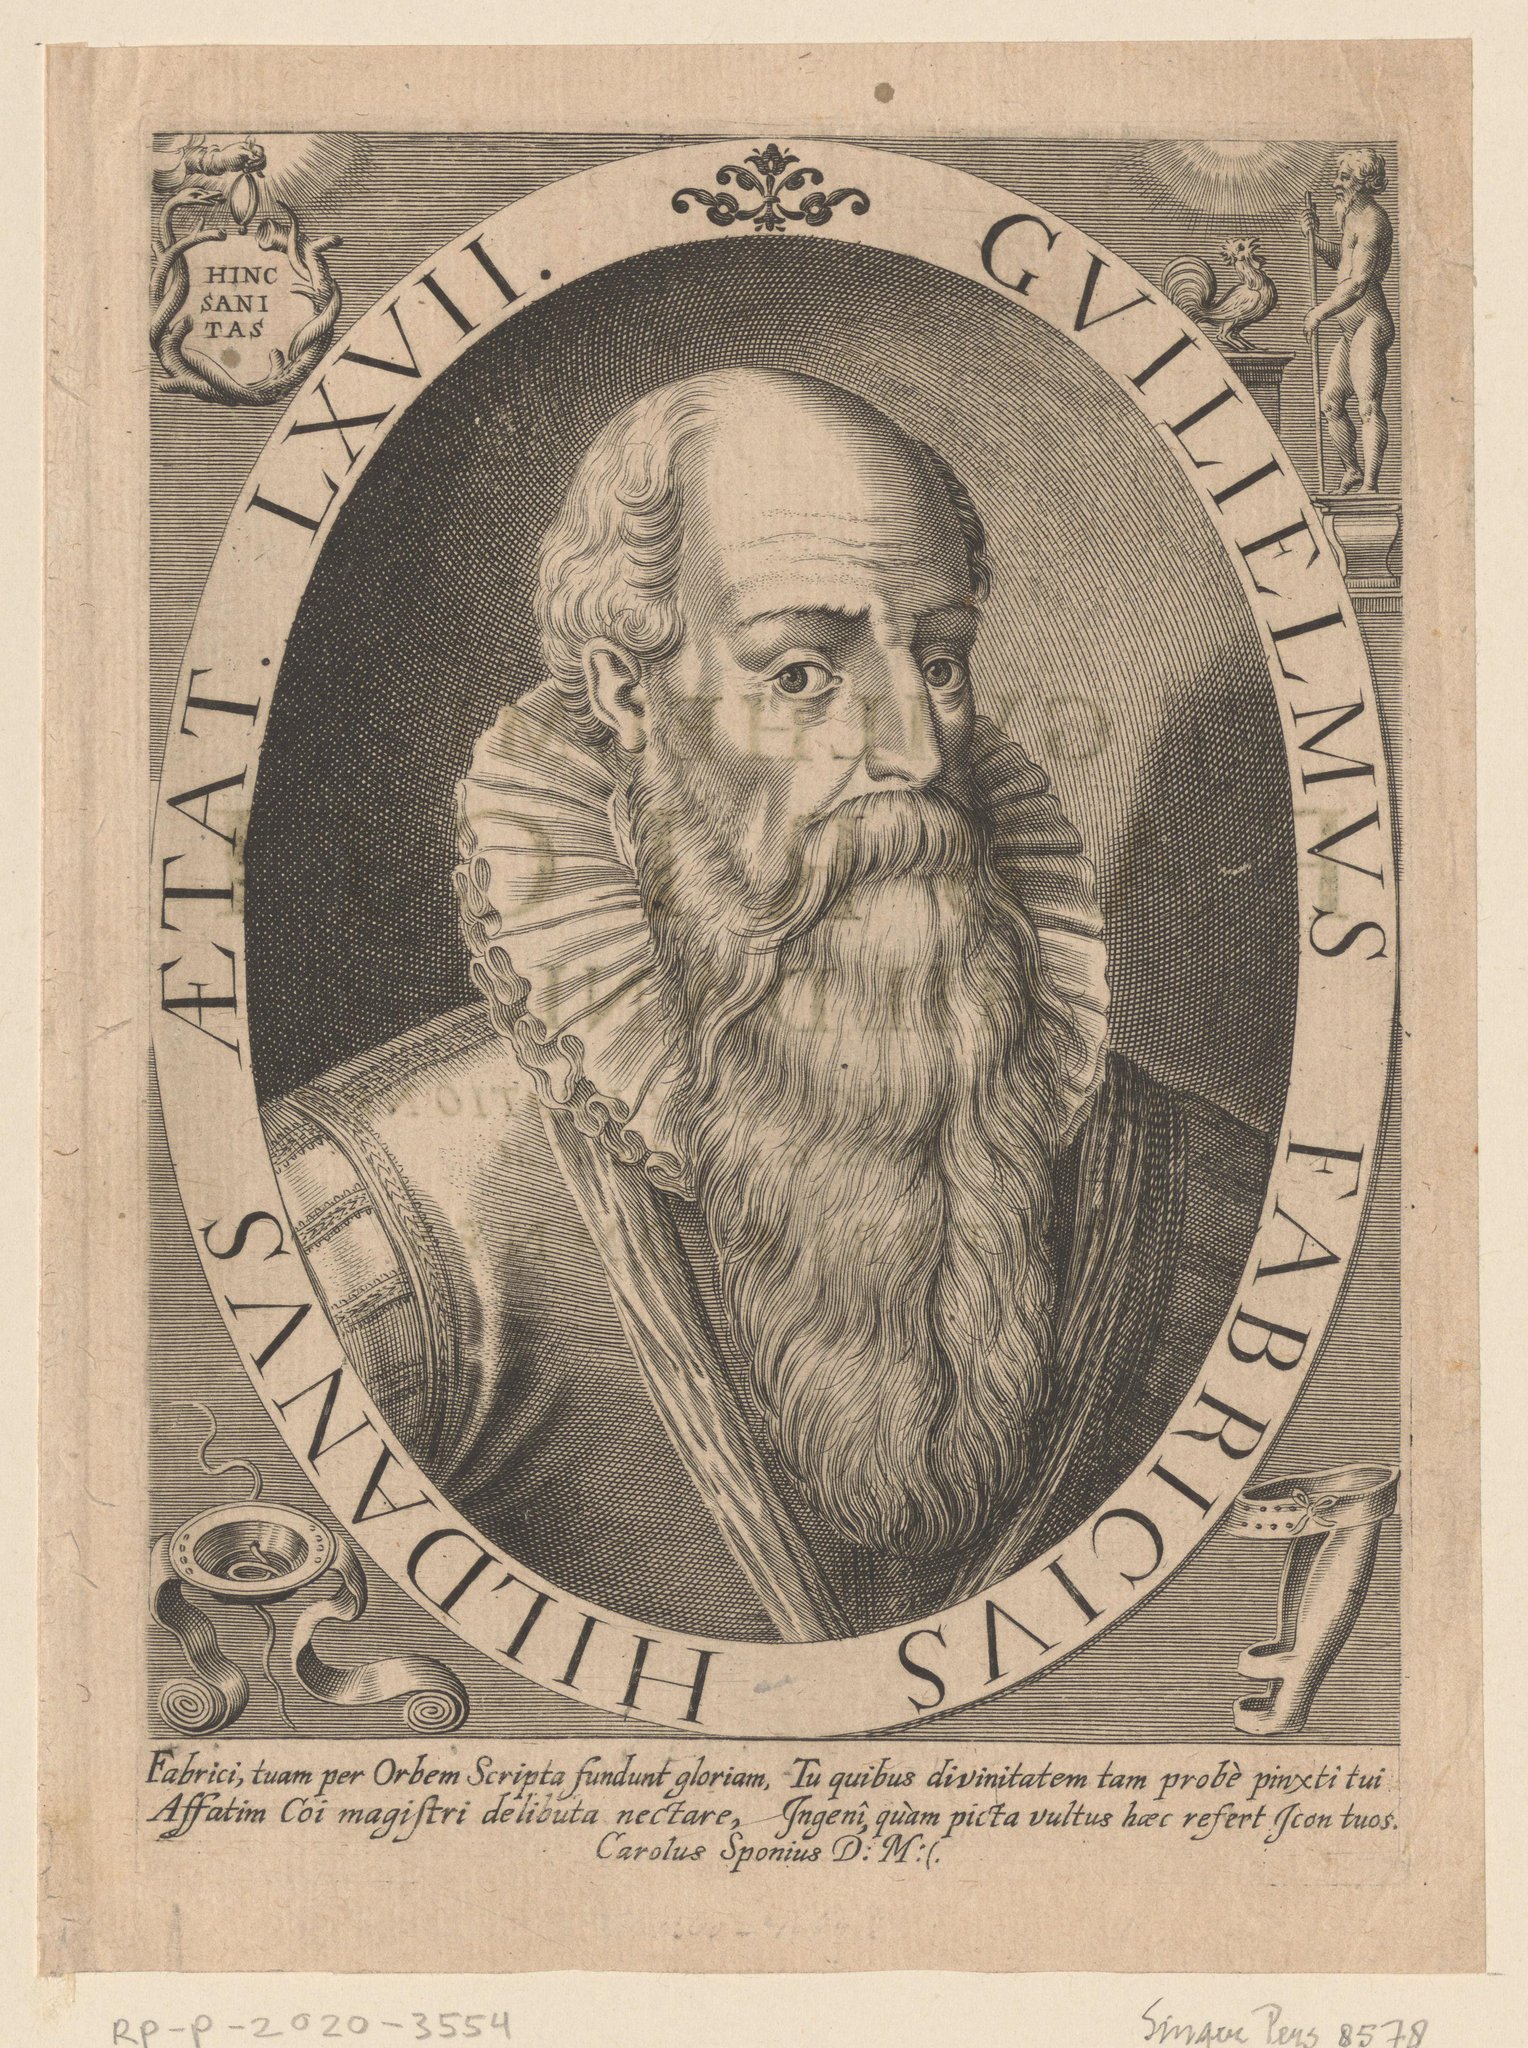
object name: book illustration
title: Portret van Wilhelm Fabry op 67-jarige leeftijd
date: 1641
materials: paper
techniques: engraving, letterpress printing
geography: lyon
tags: historical persons, medical instruments, barber; surgeon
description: Prent uit: Fabry, Wilhelm. Observationum et curationum chirurgicarum (...). Lyon: Jean Antoine Huguetan, 1641.